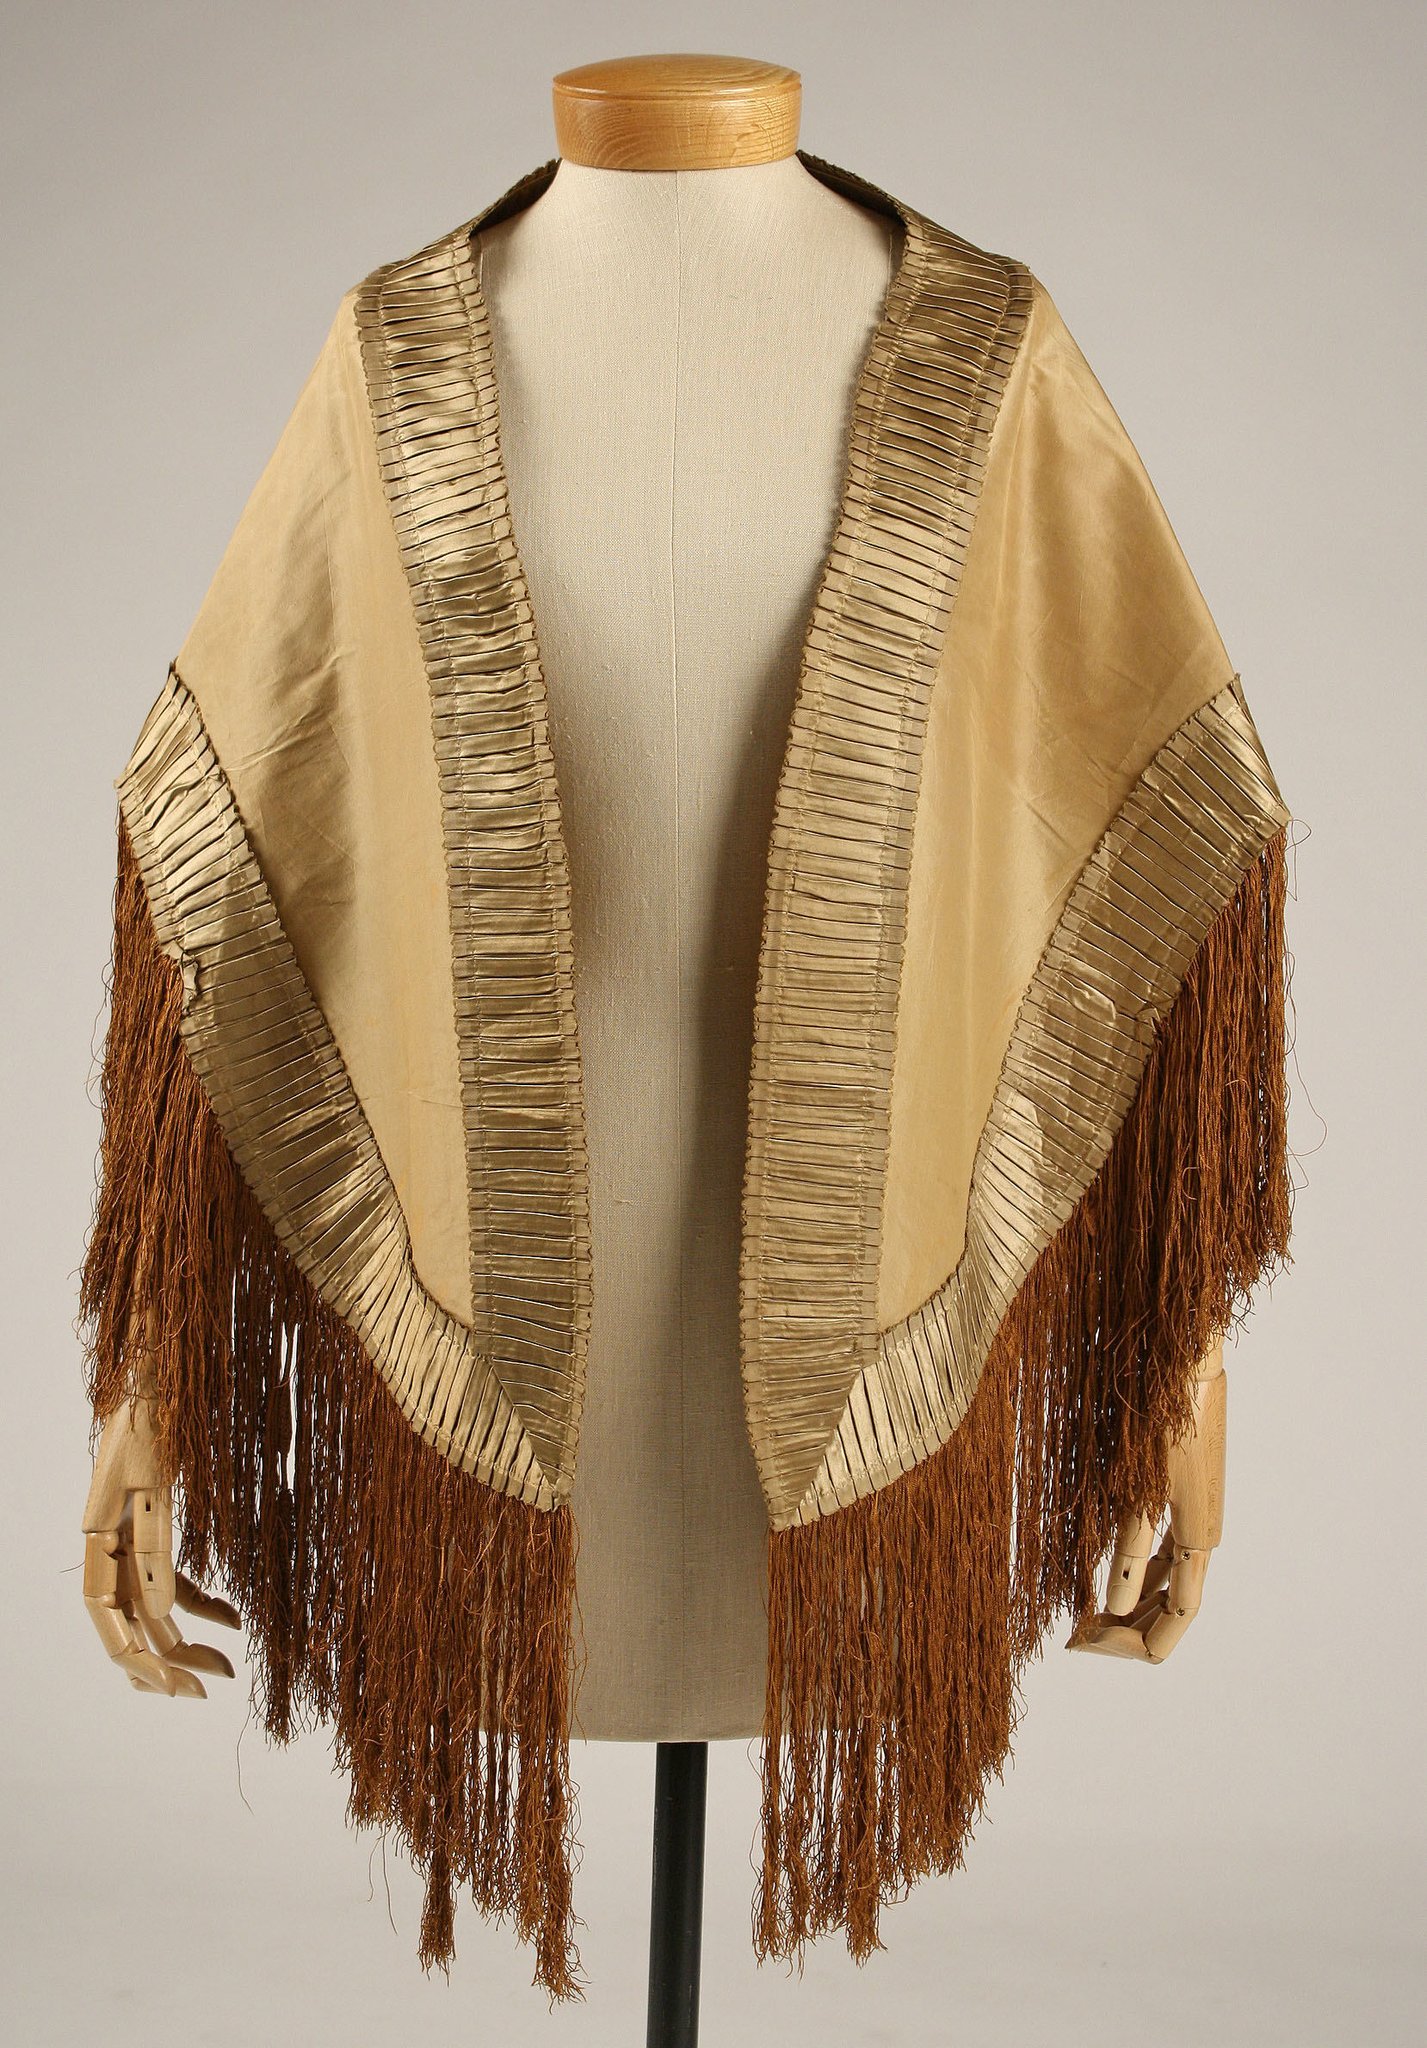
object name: pelerine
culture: american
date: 1870-1880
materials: silk